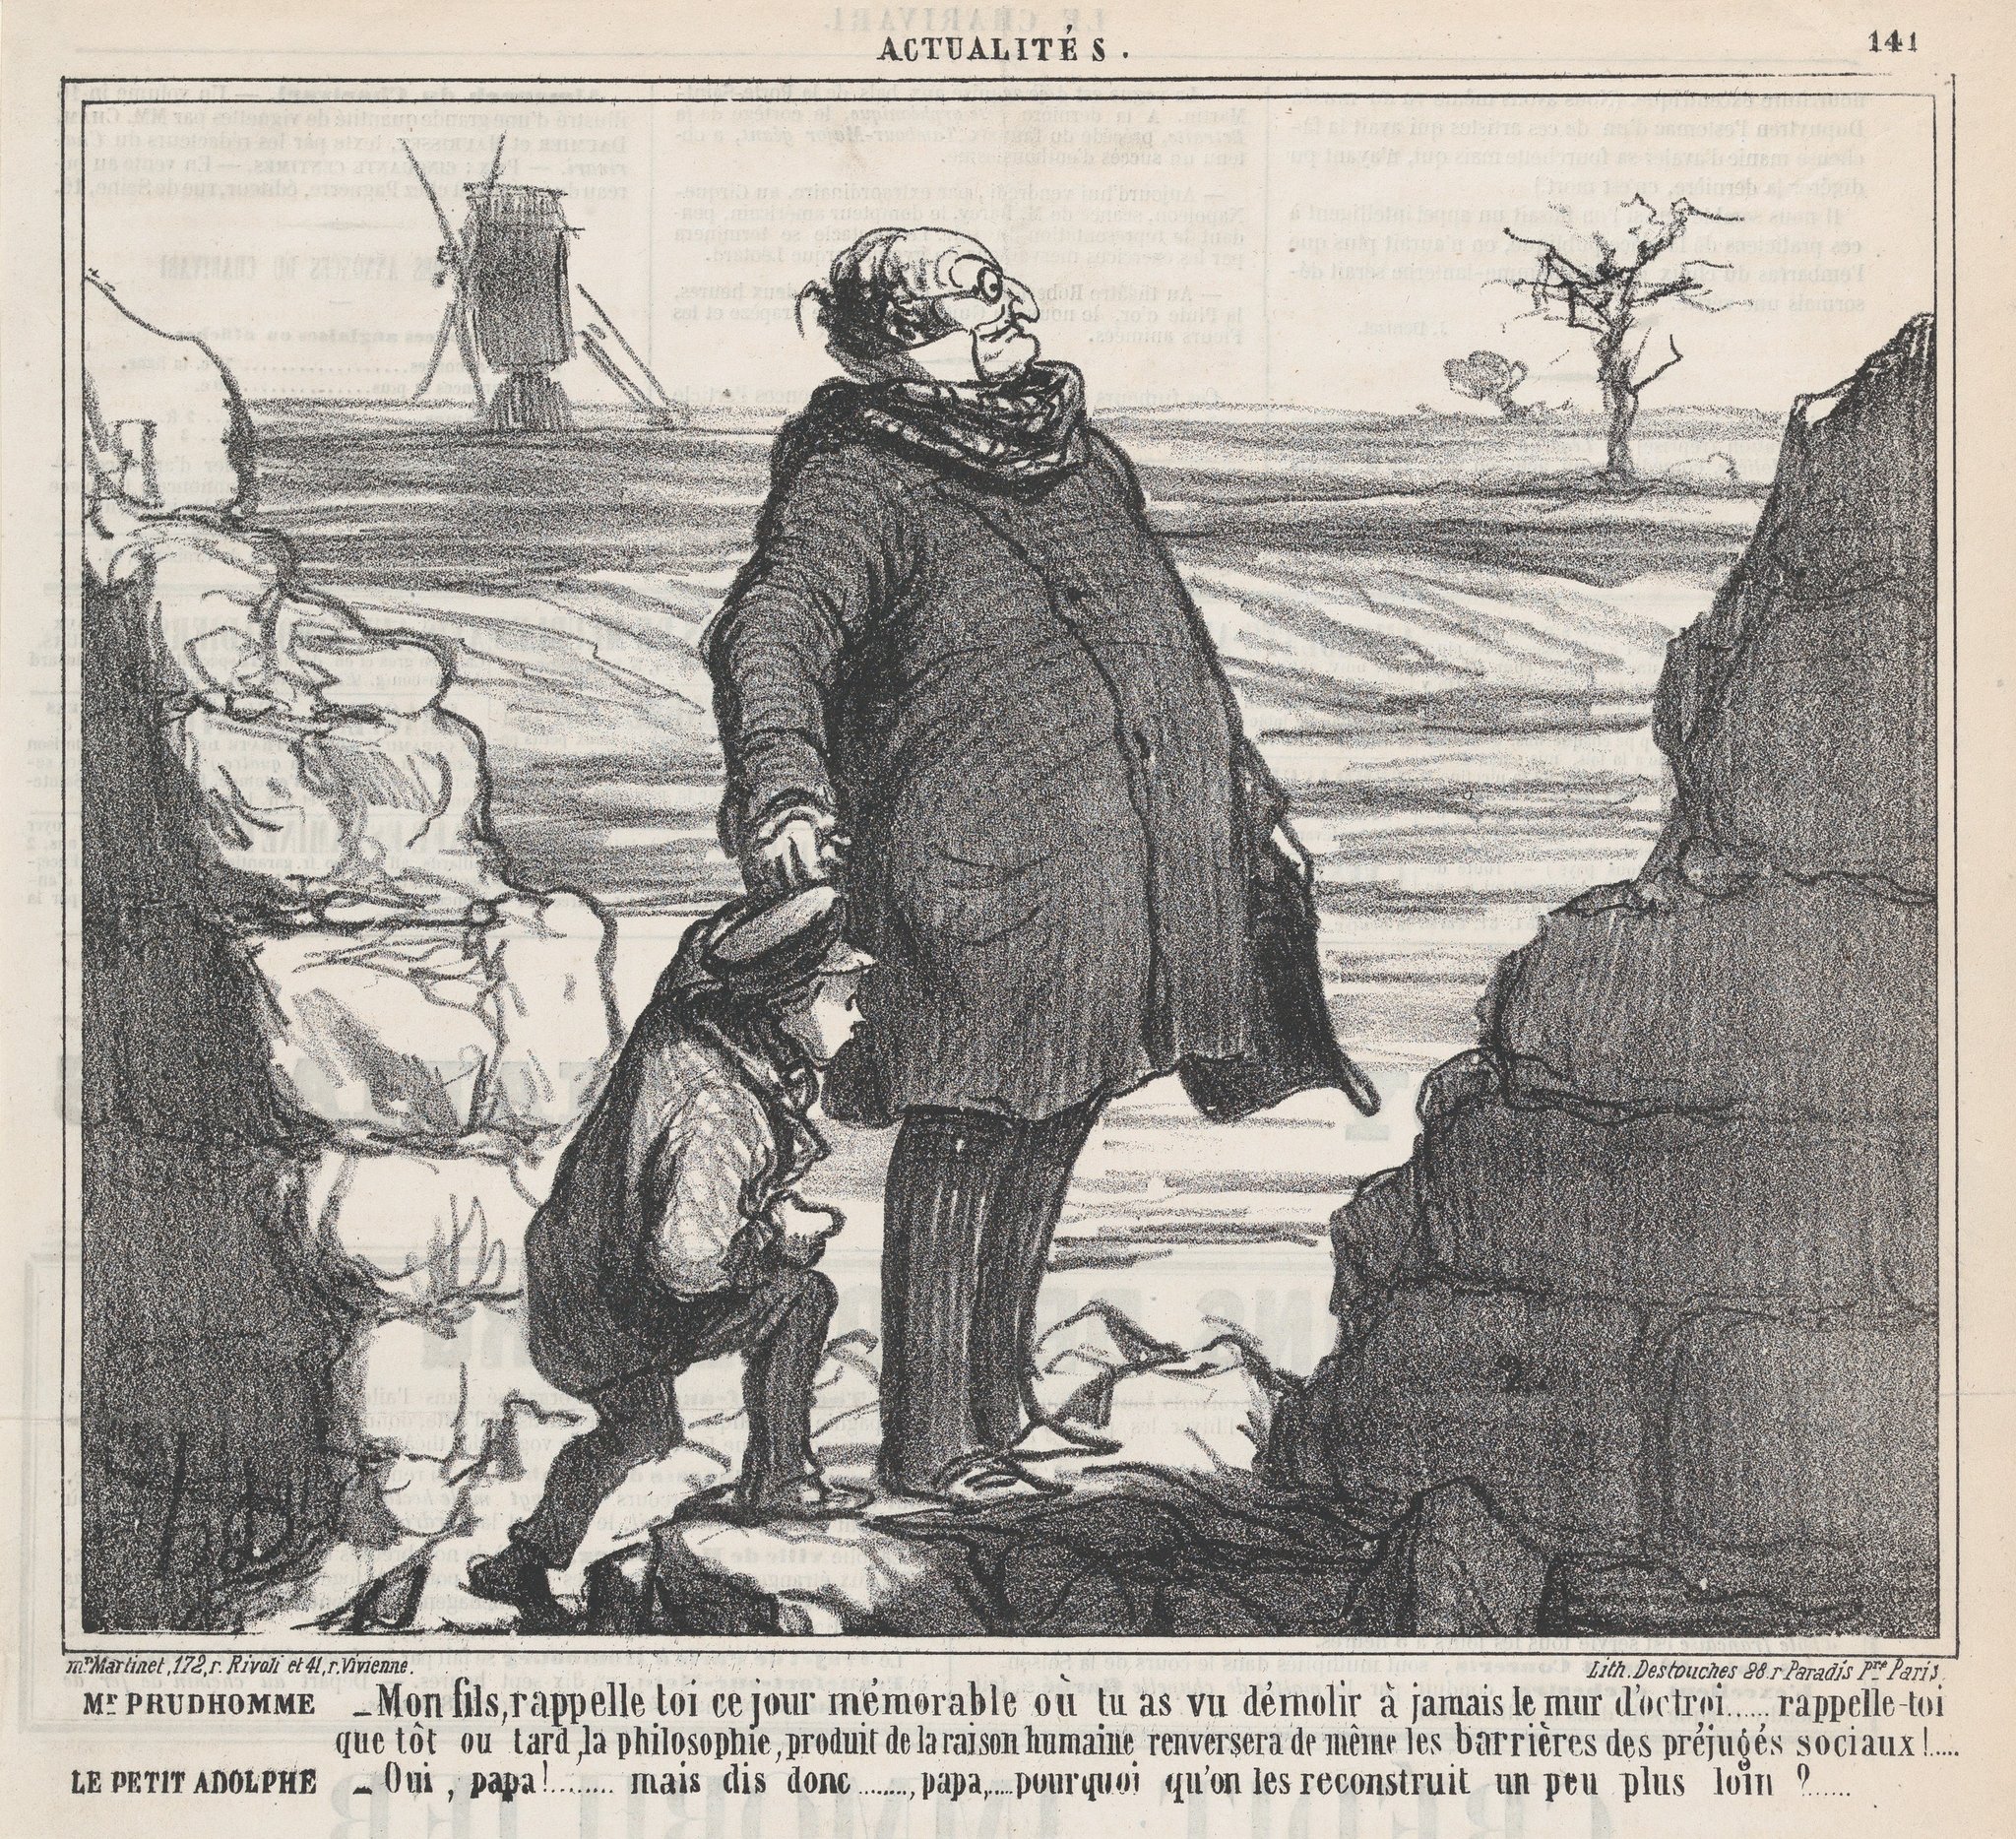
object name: print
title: Mr. Prudhomme and young Adolph, from 'News of the Day,' published in Le Charivari, January 27, 1860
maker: honoré daumier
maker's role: artist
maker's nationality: french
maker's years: 1808-1879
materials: paper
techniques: lithograph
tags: satire,boys,men